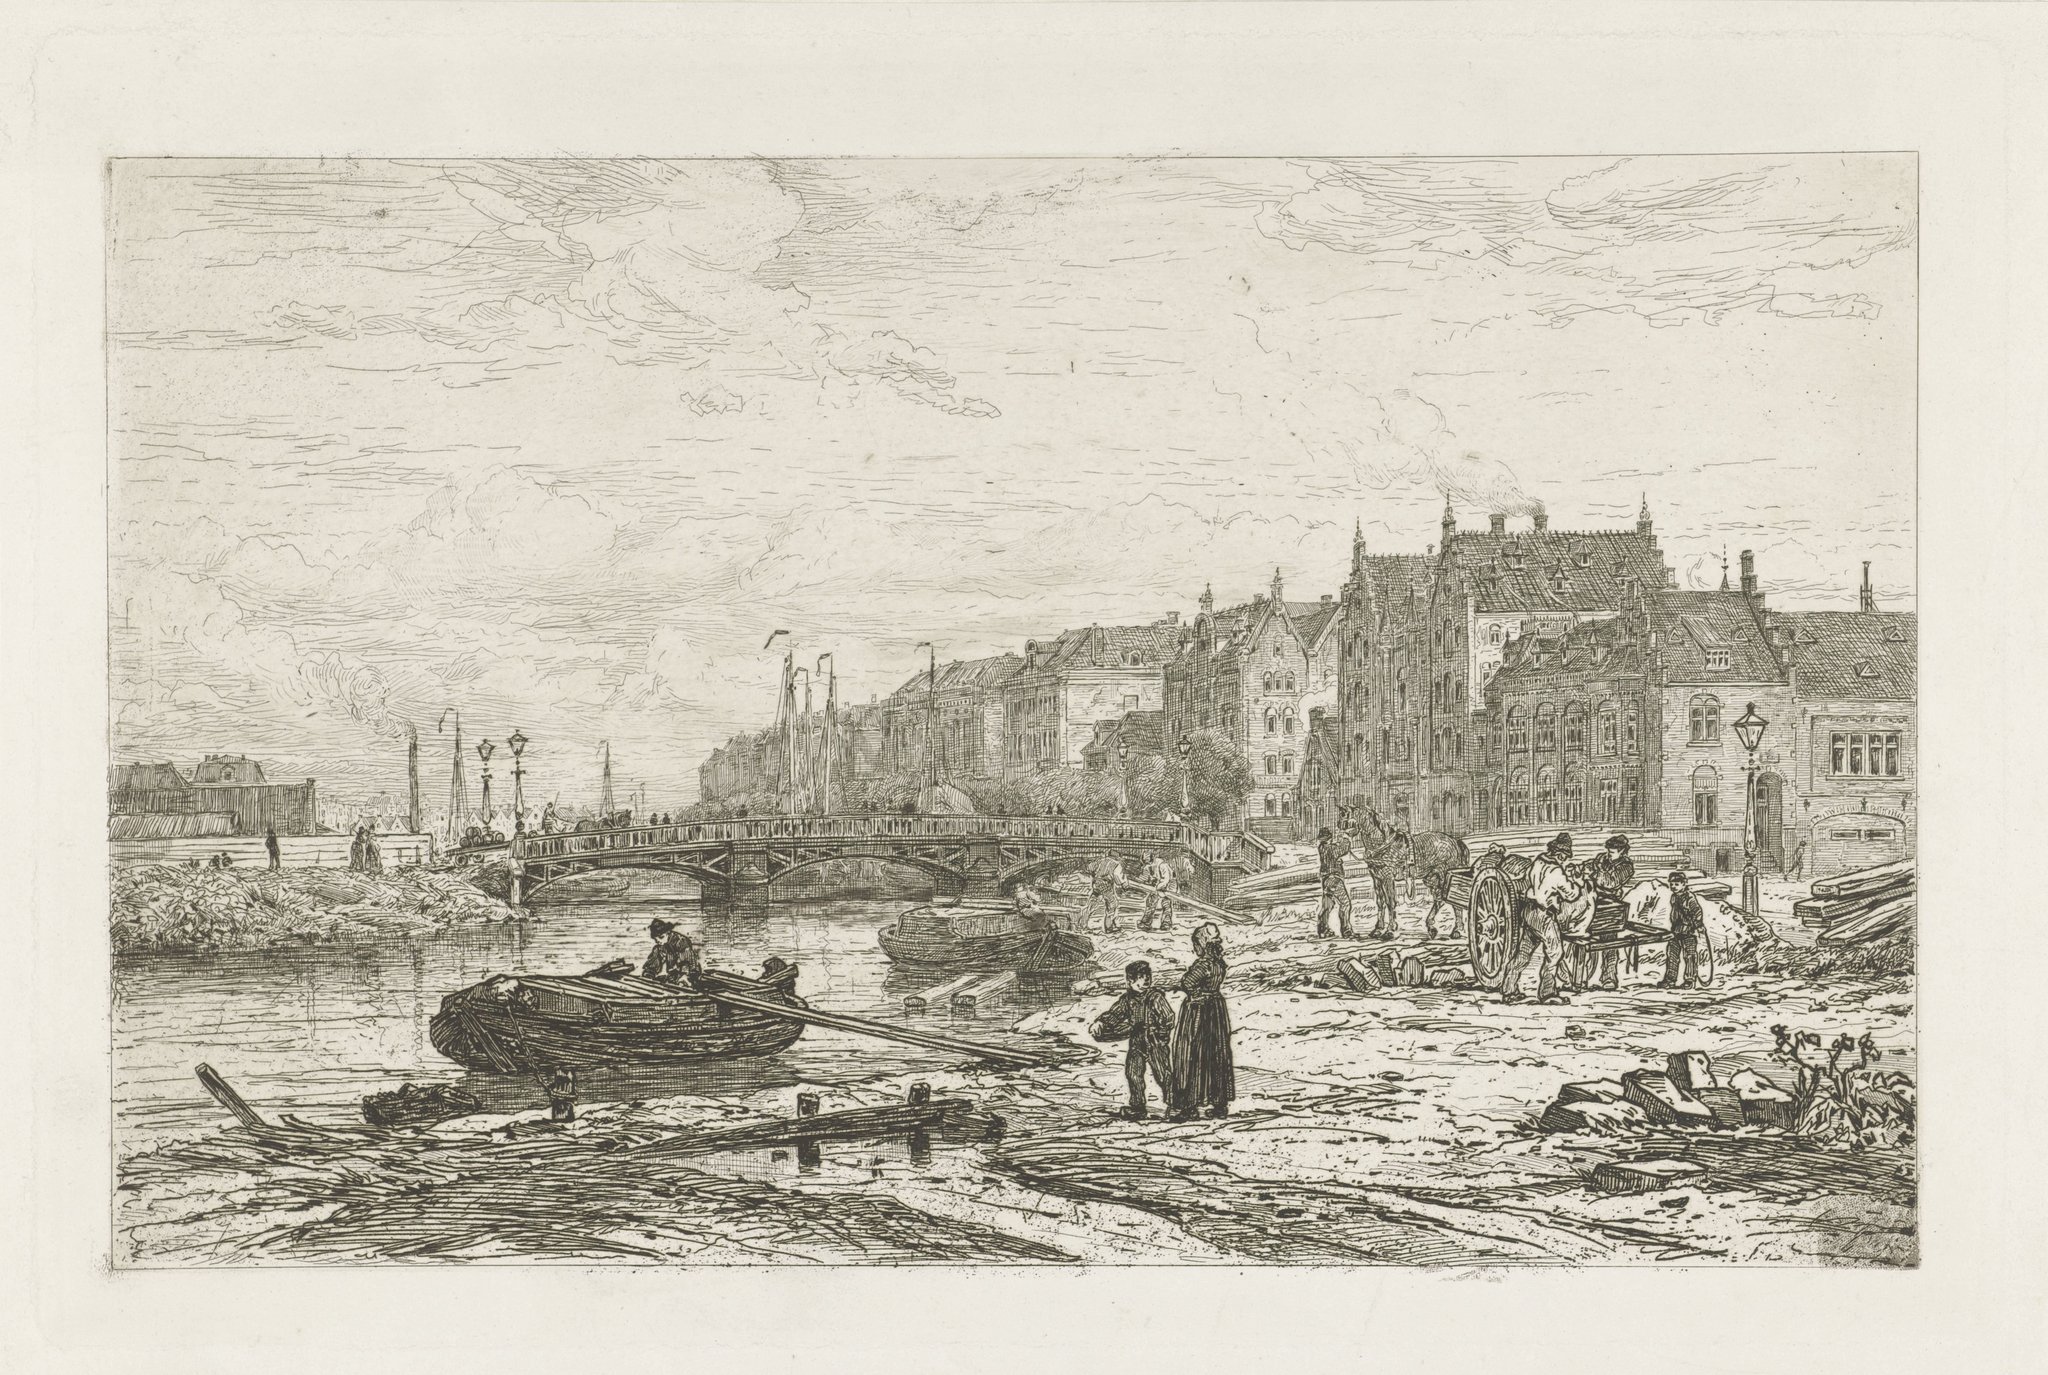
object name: print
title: Gezicht op de Stadhouderskade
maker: johan conrad greive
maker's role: draughtsman, painter, print maker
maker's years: 1837-1891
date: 1847-1891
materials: paper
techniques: etching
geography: amsterdam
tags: amsterdam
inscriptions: collector's mark: Lugt 2228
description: De Stadhouderskade met rechts de Ferdinand Bolstraat. Op de voorgrond de oever van de Amstel met een boot.